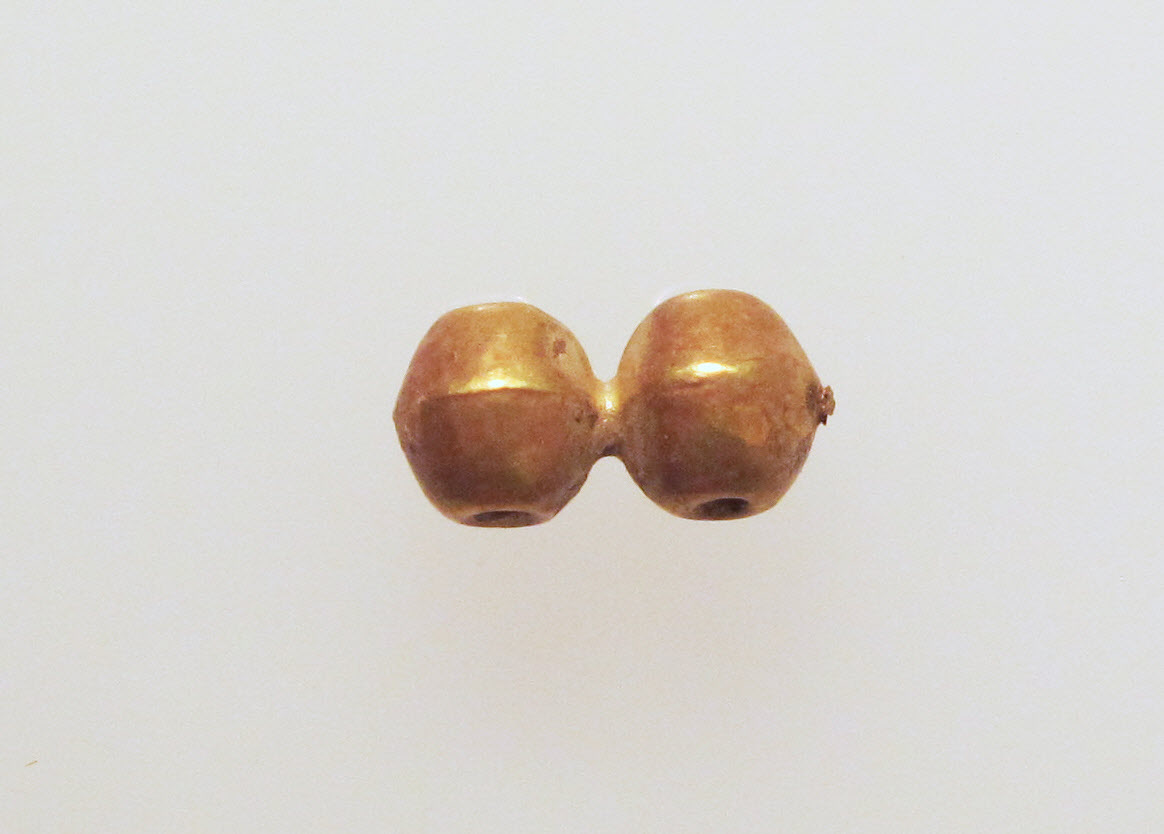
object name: bead, control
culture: cypriot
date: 3900 BCE-100 CE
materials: gold